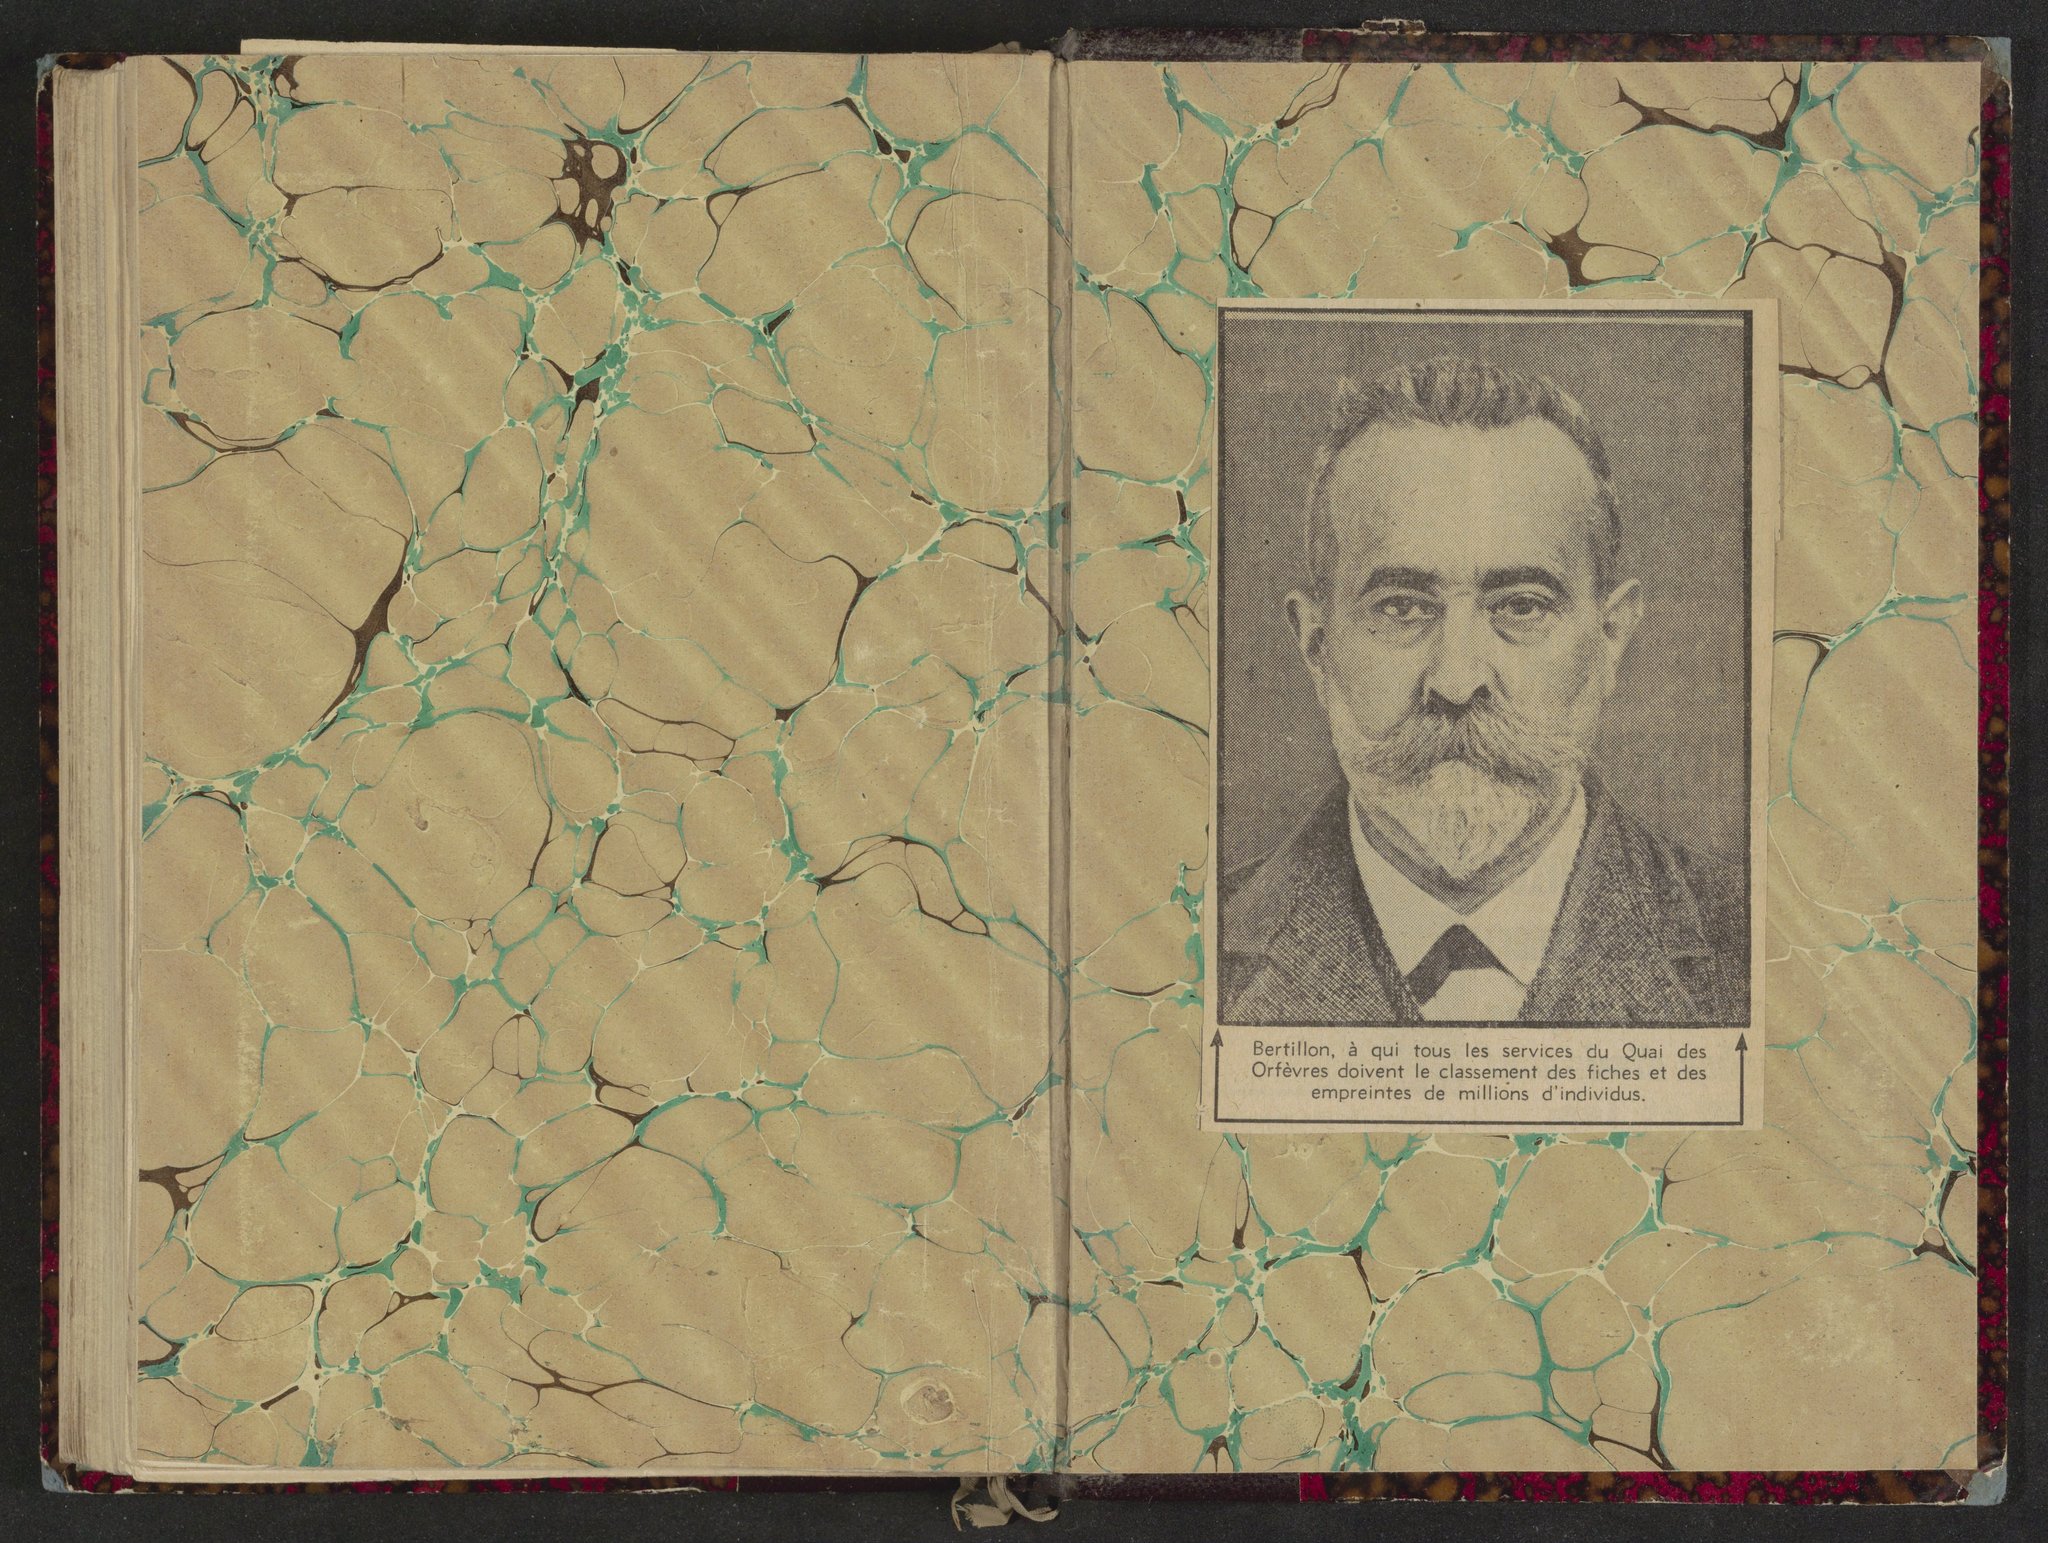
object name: page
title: Portret van Alphonse Bertillon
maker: Anonymous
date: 1910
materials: paper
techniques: offset printed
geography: france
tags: alphonse bertillon, head (human) (+ front view), france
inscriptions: inscription: ‘Bertillon, à qui tous les services du Quai des Orfèvres doivent le classement des fiches et des empreintes de millions d'individus.’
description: Prent zat los in boek tussen plaat 79 en 80.